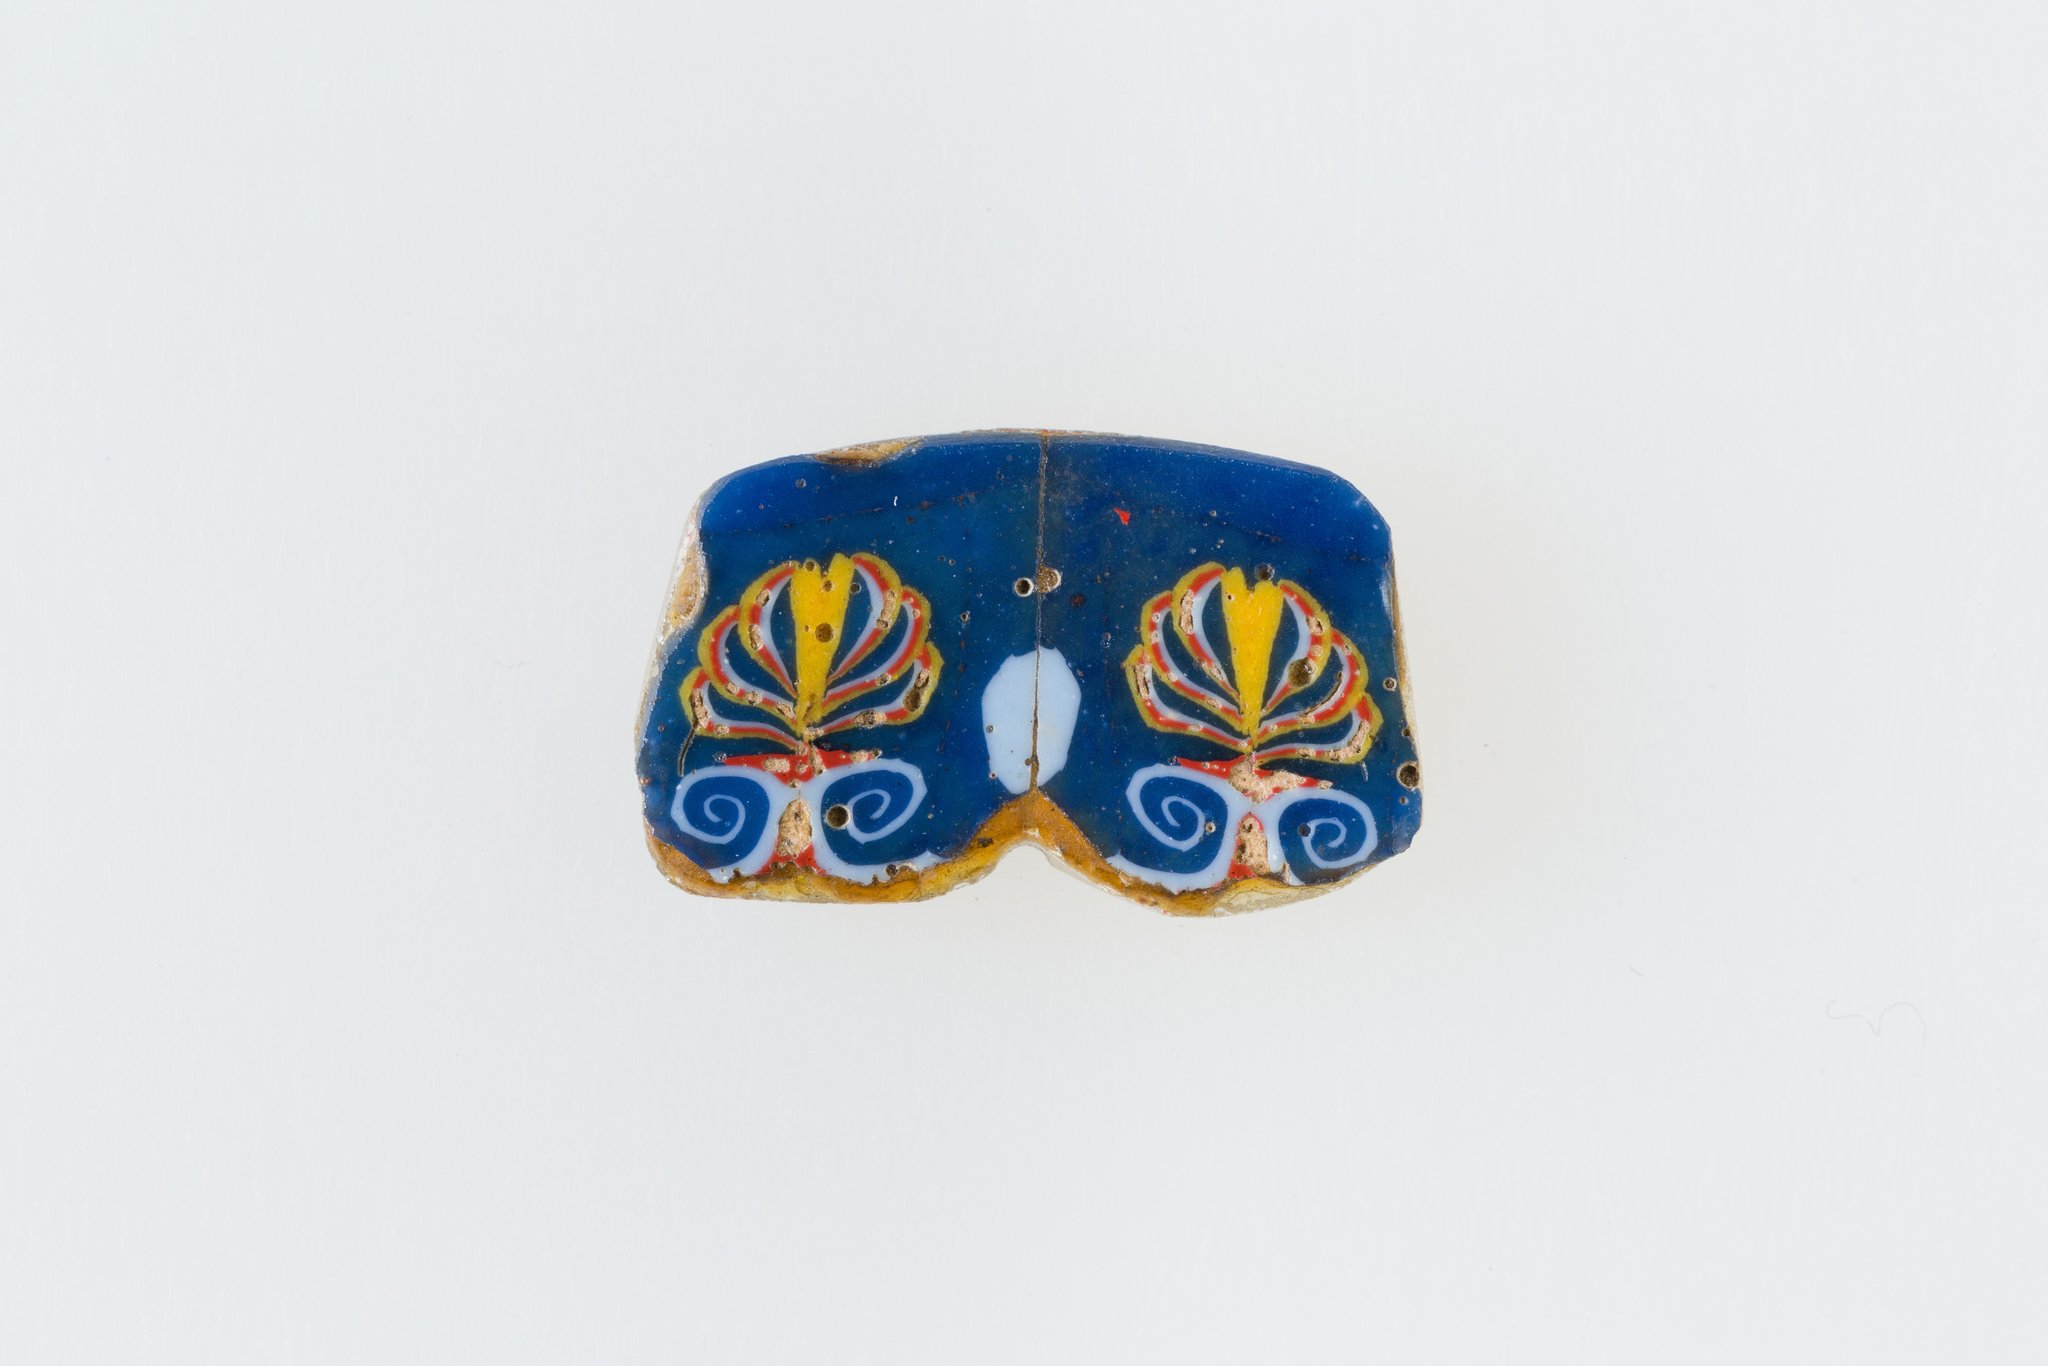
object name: inlay, palmette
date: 100 BCE-100 CE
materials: glass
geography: egypt